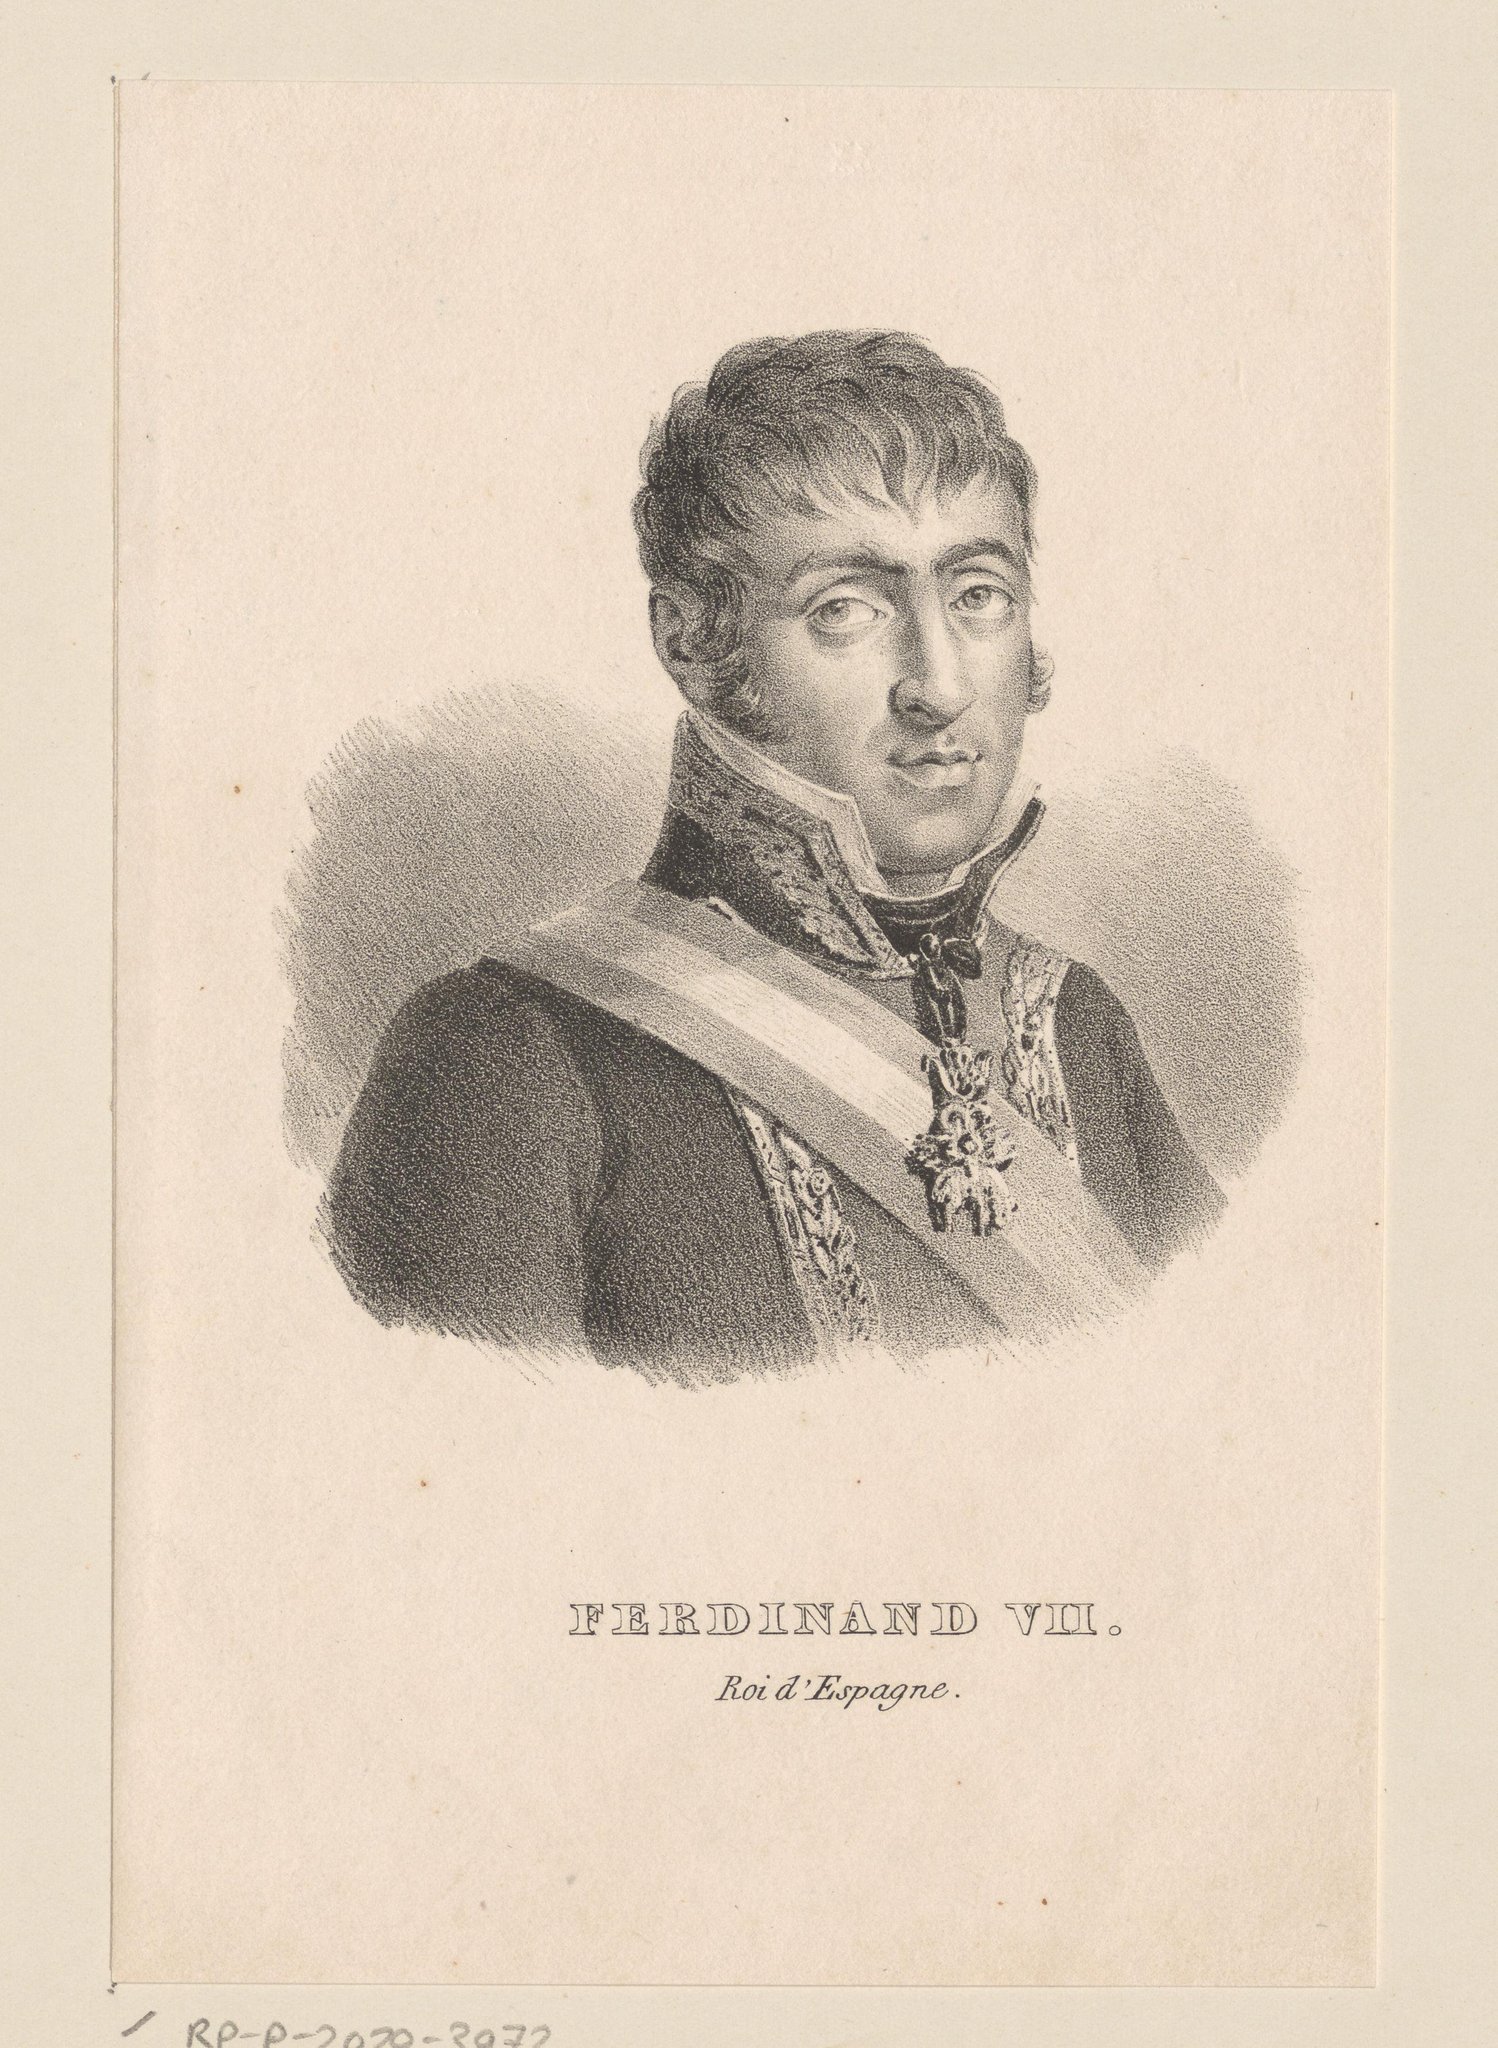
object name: print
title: Portret van Ferdinand VII van Spanje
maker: Anonymous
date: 1814-1850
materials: paper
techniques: lithograph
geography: france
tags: ferdinand vii (koning van spanje), historical persons, knighthood order of the golden fleece, king